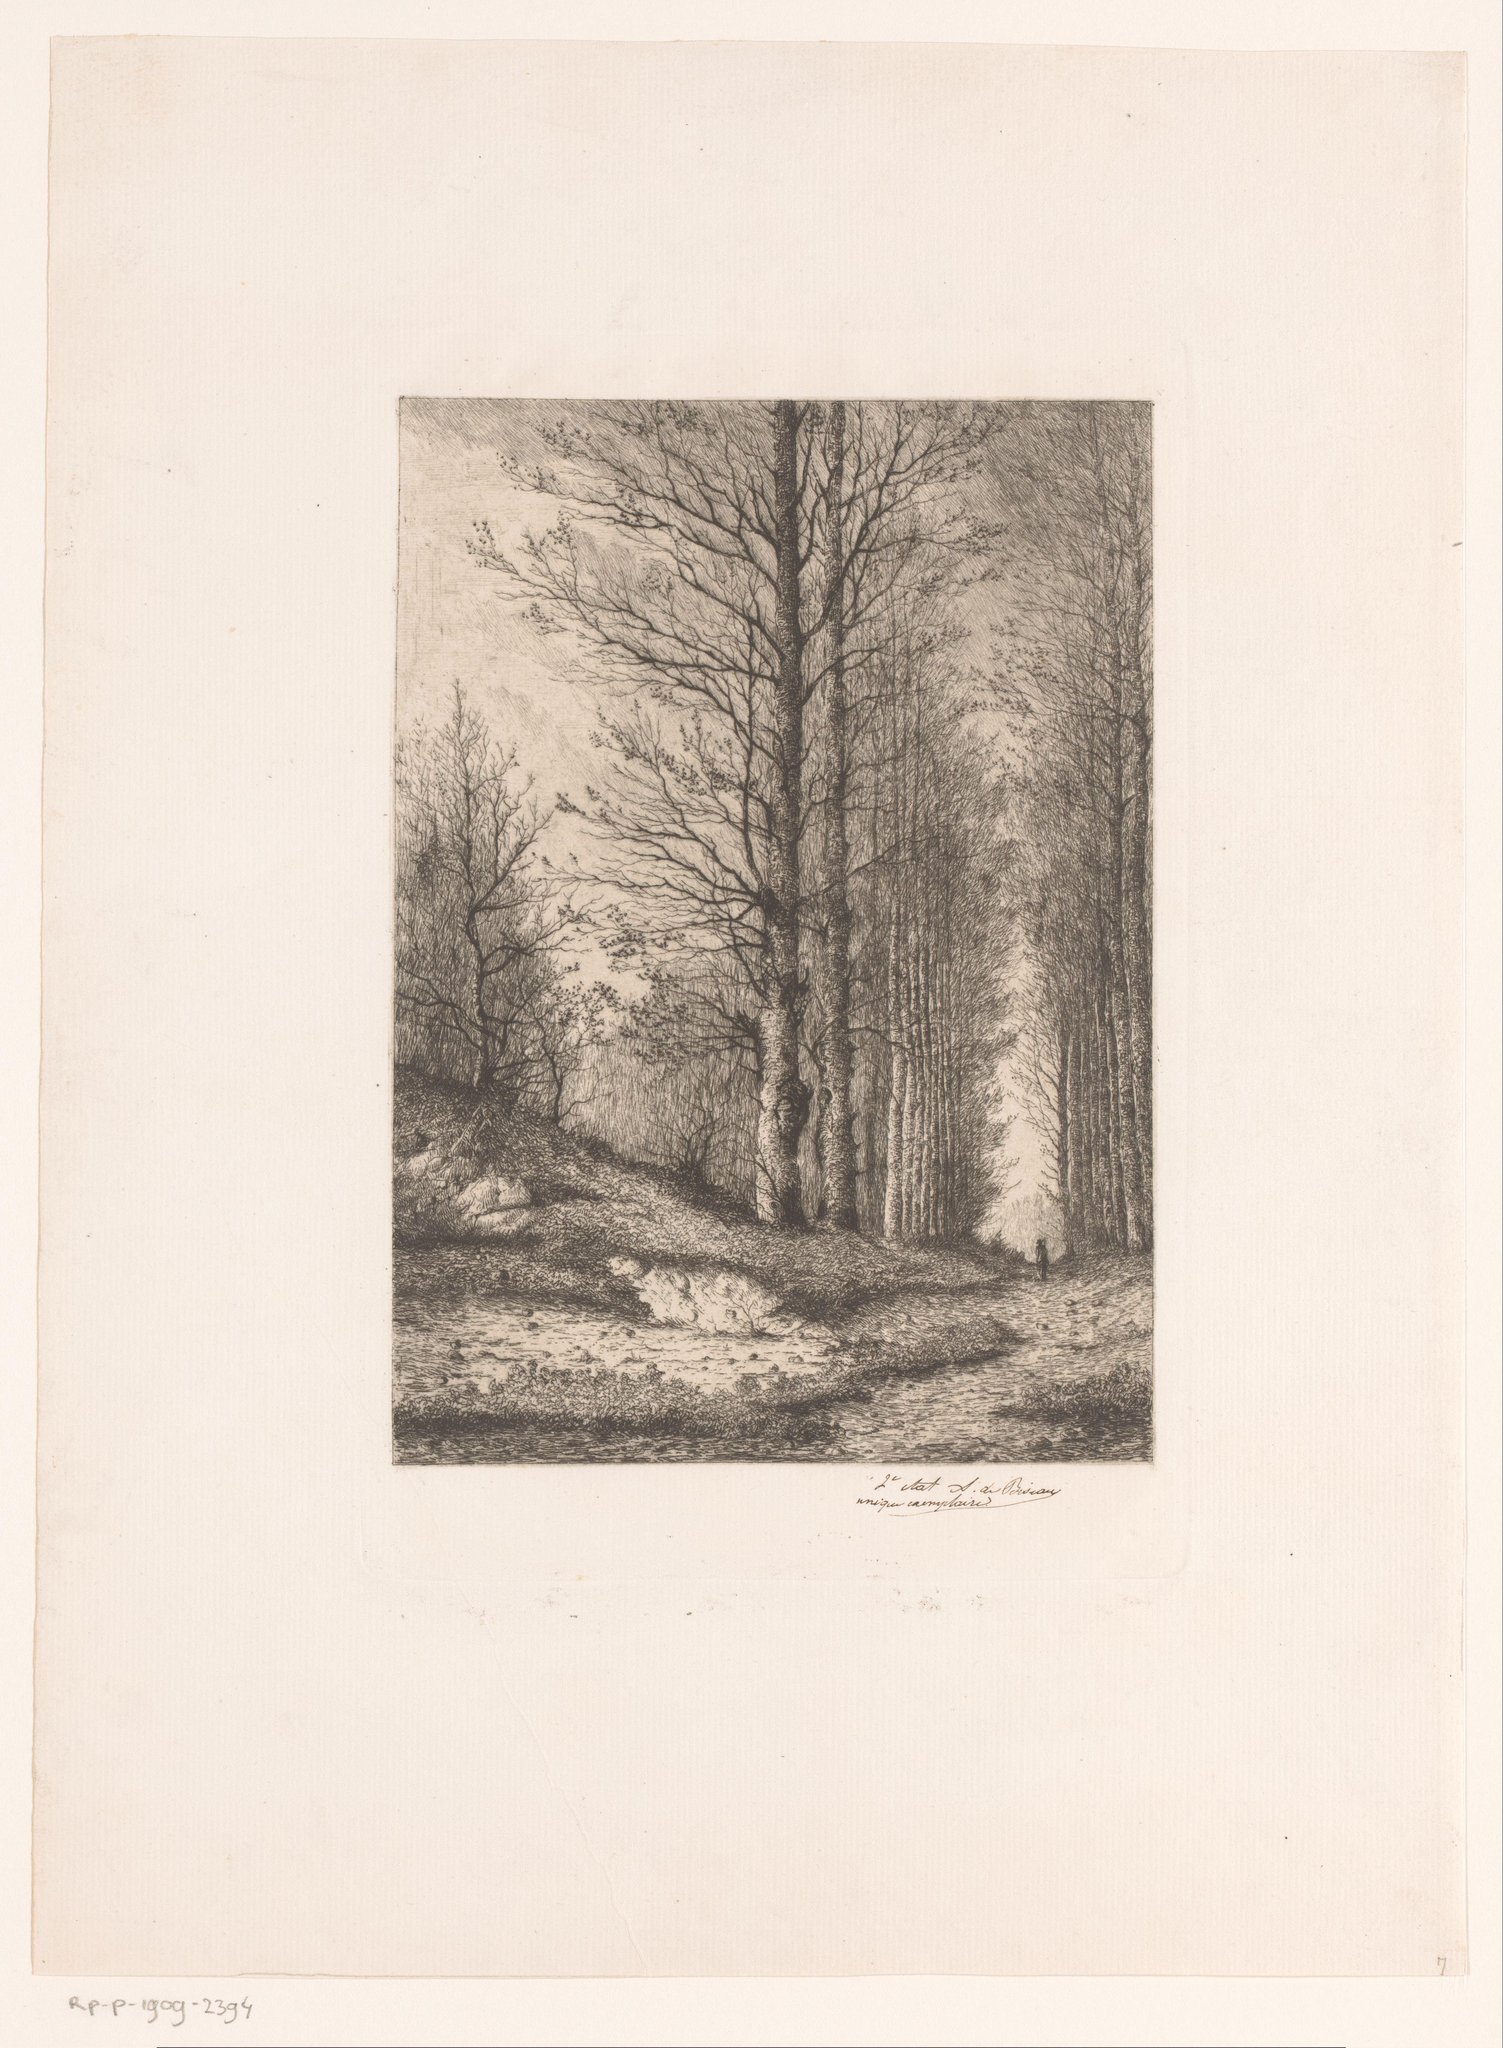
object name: print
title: Les dernières feuilles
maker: aristide de biseau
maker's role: print maker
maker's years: 1844-1883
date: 1873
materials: paper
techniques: etching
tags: horse throwing rider, trees: beech, forest path or lane, autumn, fall, 'autumnus'; 'autunno' (ripa)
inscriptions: inscription: ‘2e etat unique exemplaire’, collector's mark: Lugt 2228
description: Een latere staat van deze prent is gebruikt in: Album du Journal des Beaux-Arts. Antwerpen, s.n., 1873.